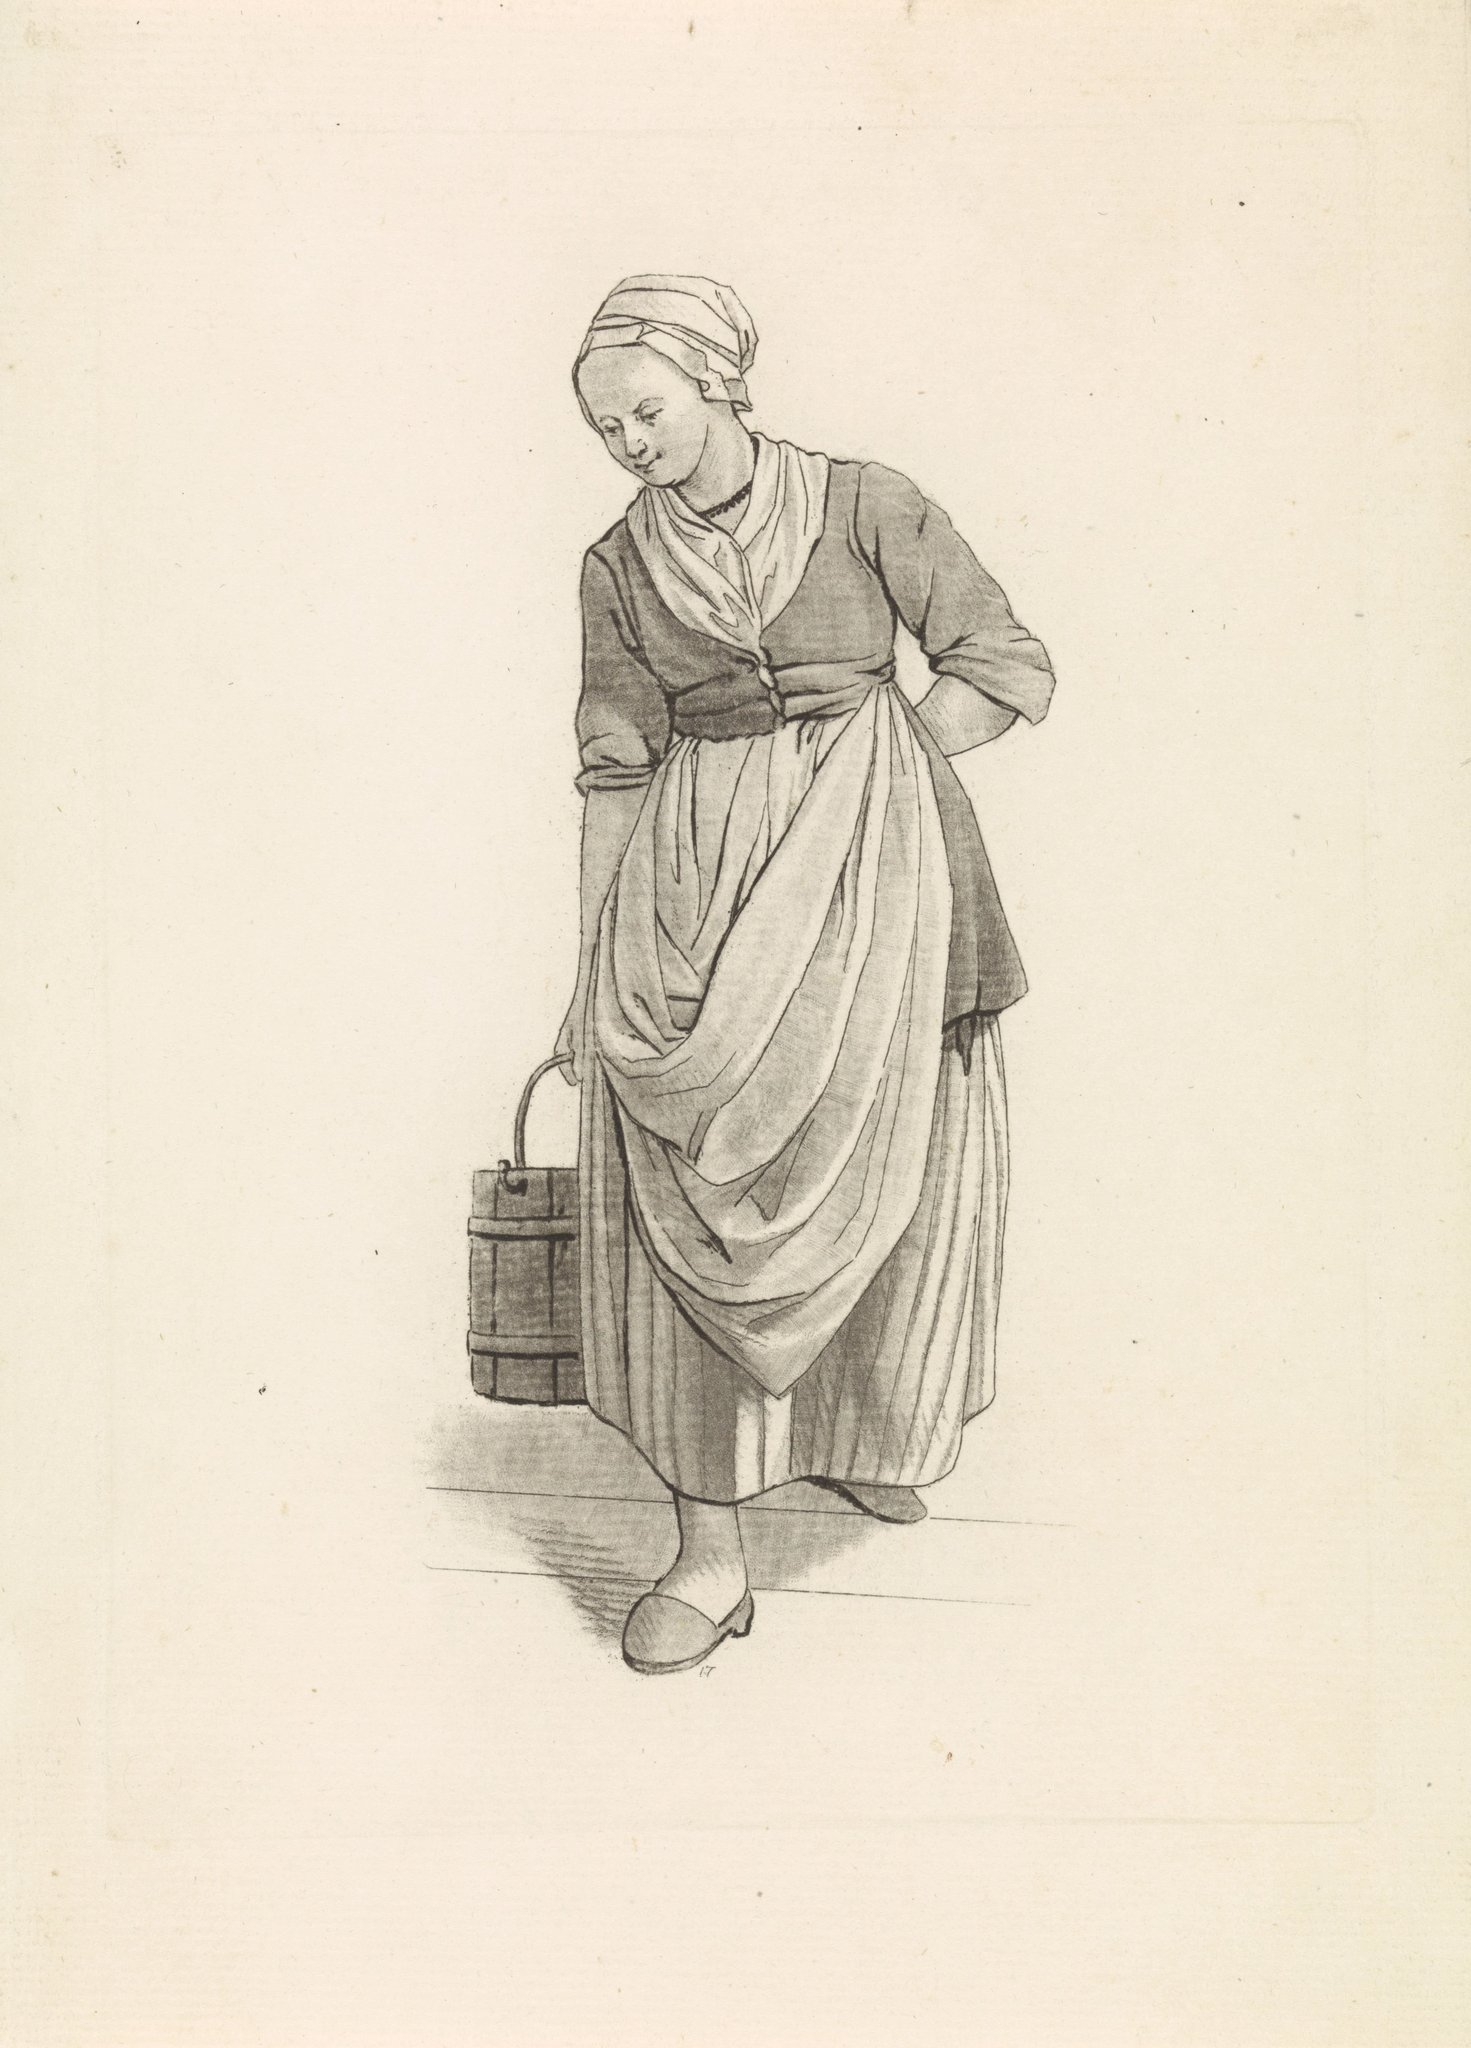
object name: print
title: Melkmeisje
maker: mathias de sallieth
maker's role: print maker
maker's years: 1749-1791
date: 1772-1791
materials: paper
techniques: aquatint, printmaking, etching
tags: milkmaid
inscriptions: collector's mark: Lugt 2228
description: De prent verscheen vanaf 1818 tevens als onderdeel van een 33-delige reeks prenten door Mathias de Sallieth, samengebonden in: Perkois, Jacobus, Prins, Johannes Huibert. Verzameling van verschillende gekleede mans- en vrouwenstanden, ter oefening van jonge schilders en liefhebbers. Rotterdam: Johannes Immerzeel, 1818.